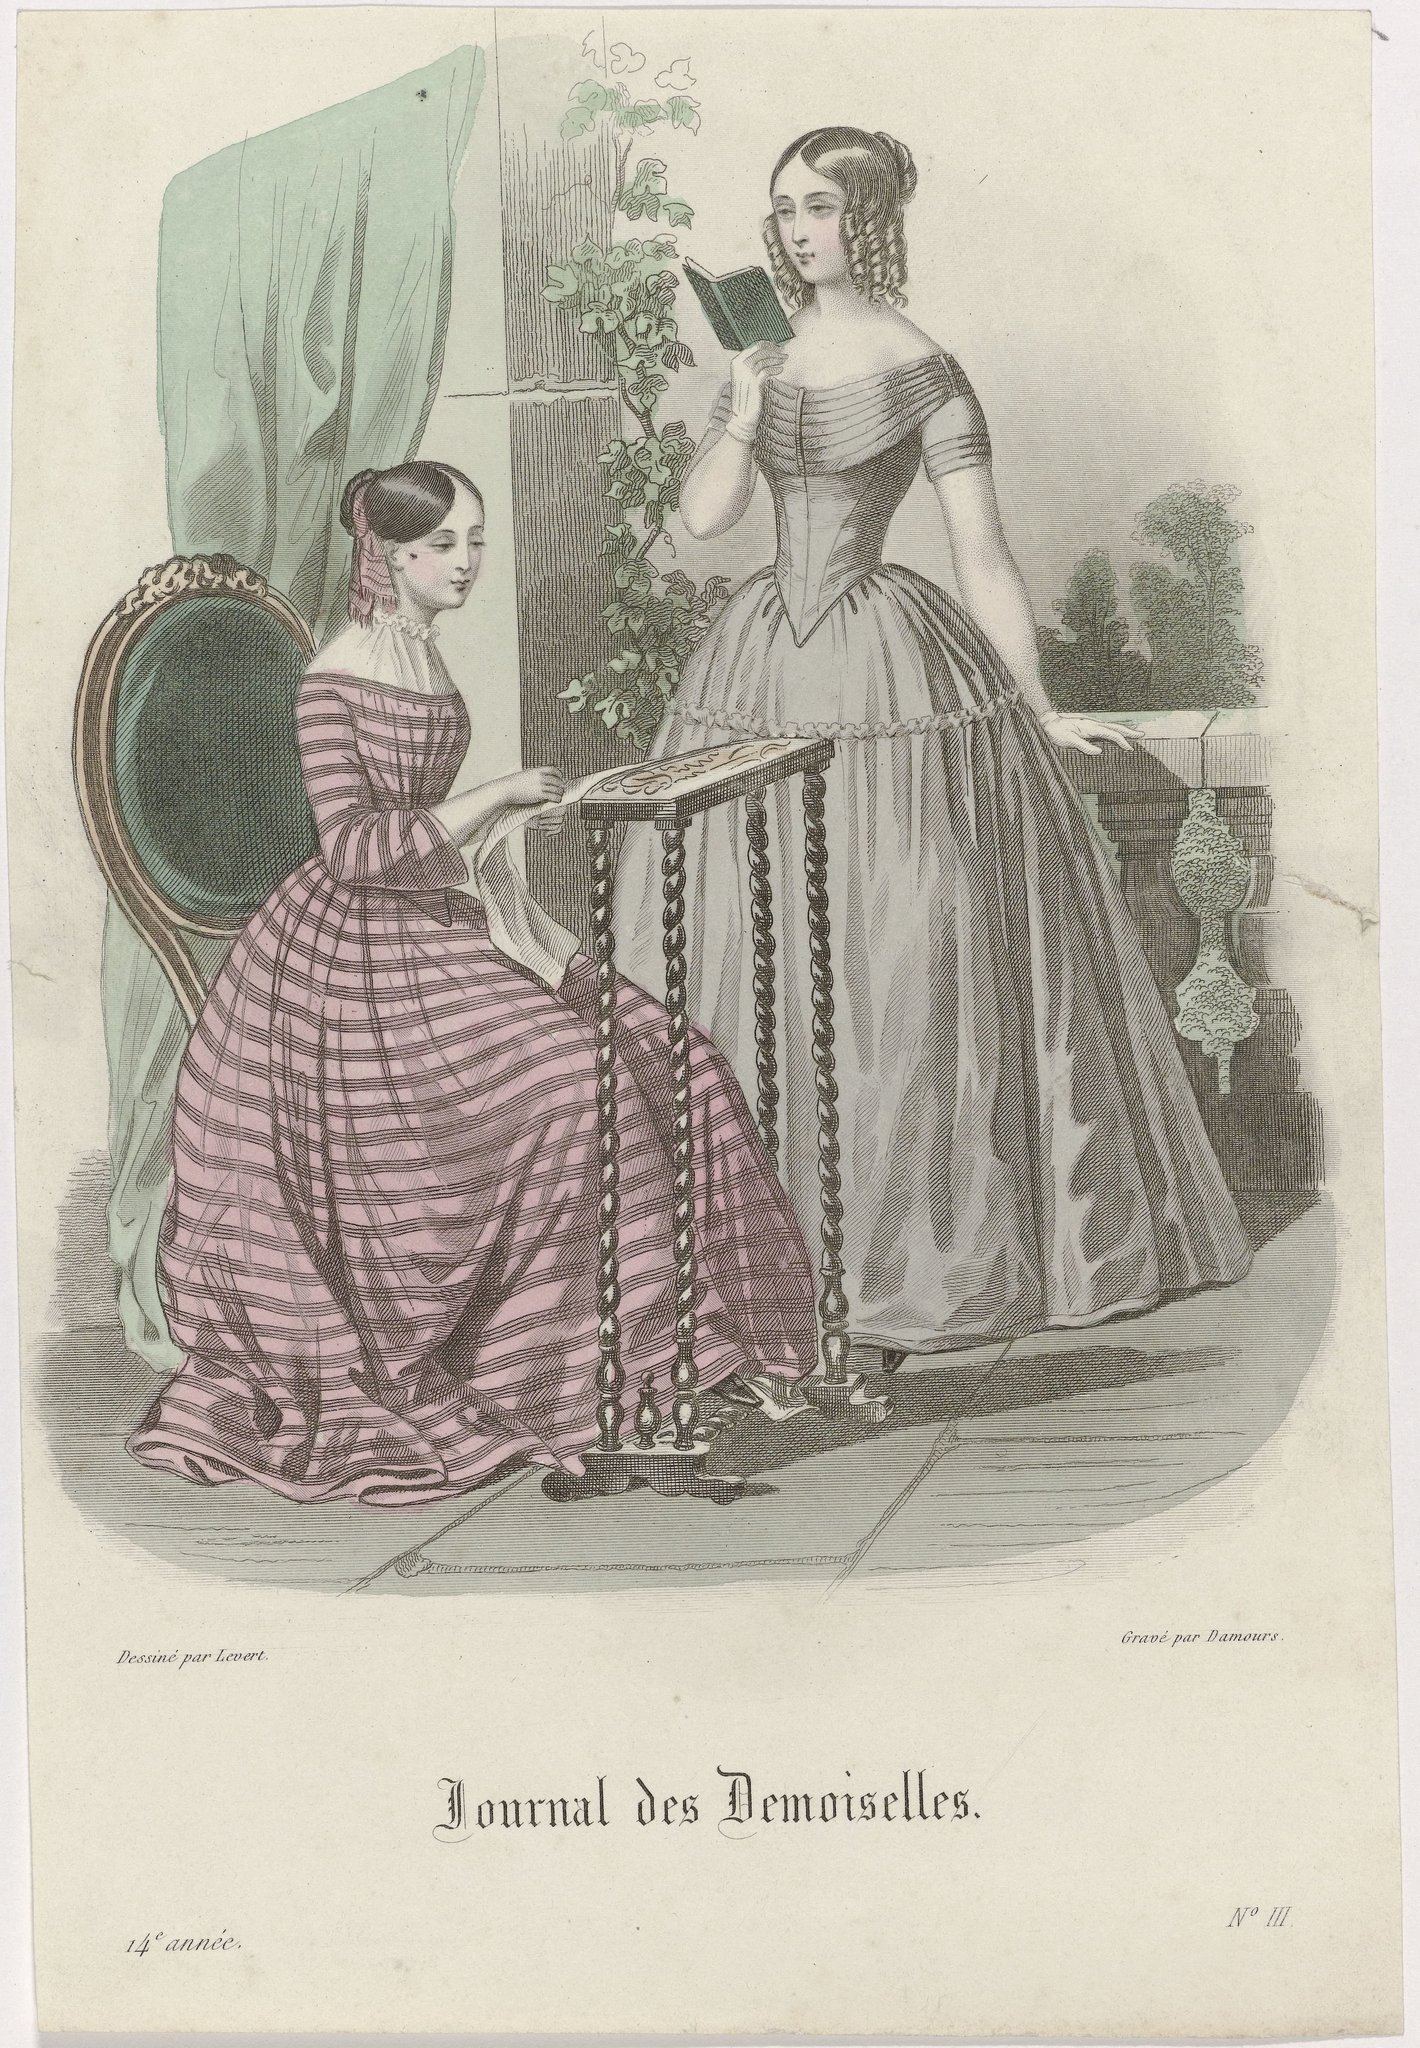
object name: fashion print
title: Journal des Demoiselles, Franse editie, 1847, 14e année, No. III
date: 1847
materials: paper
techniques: engraving, hand coloring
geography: paris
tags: gloves, mittens (short gloves) (+ women's clothes), fashion plates, shoes, sandals (+ women's clothes), dress, gown (+ women's clothes), book - mm - book open, (other forms of) needlework, e.g.: crocheting, knitting, embroidering, neck-gear ~ clothing (+ women's clothes)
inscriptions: title: ‘Journal des Demoiselles’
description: Twee vrouwen op een balkon, van wie één achter een borduurraam zit en de ander een geopend boek in de hand heeft. Links: roze gestreepte japon met boothals en driekwart mouwen. Rechts: grijze japon met boothals, korte mouwen en puntig lijfje. Prent uit het modetijdschrift Journal des Demoiselles (1833 -1922).